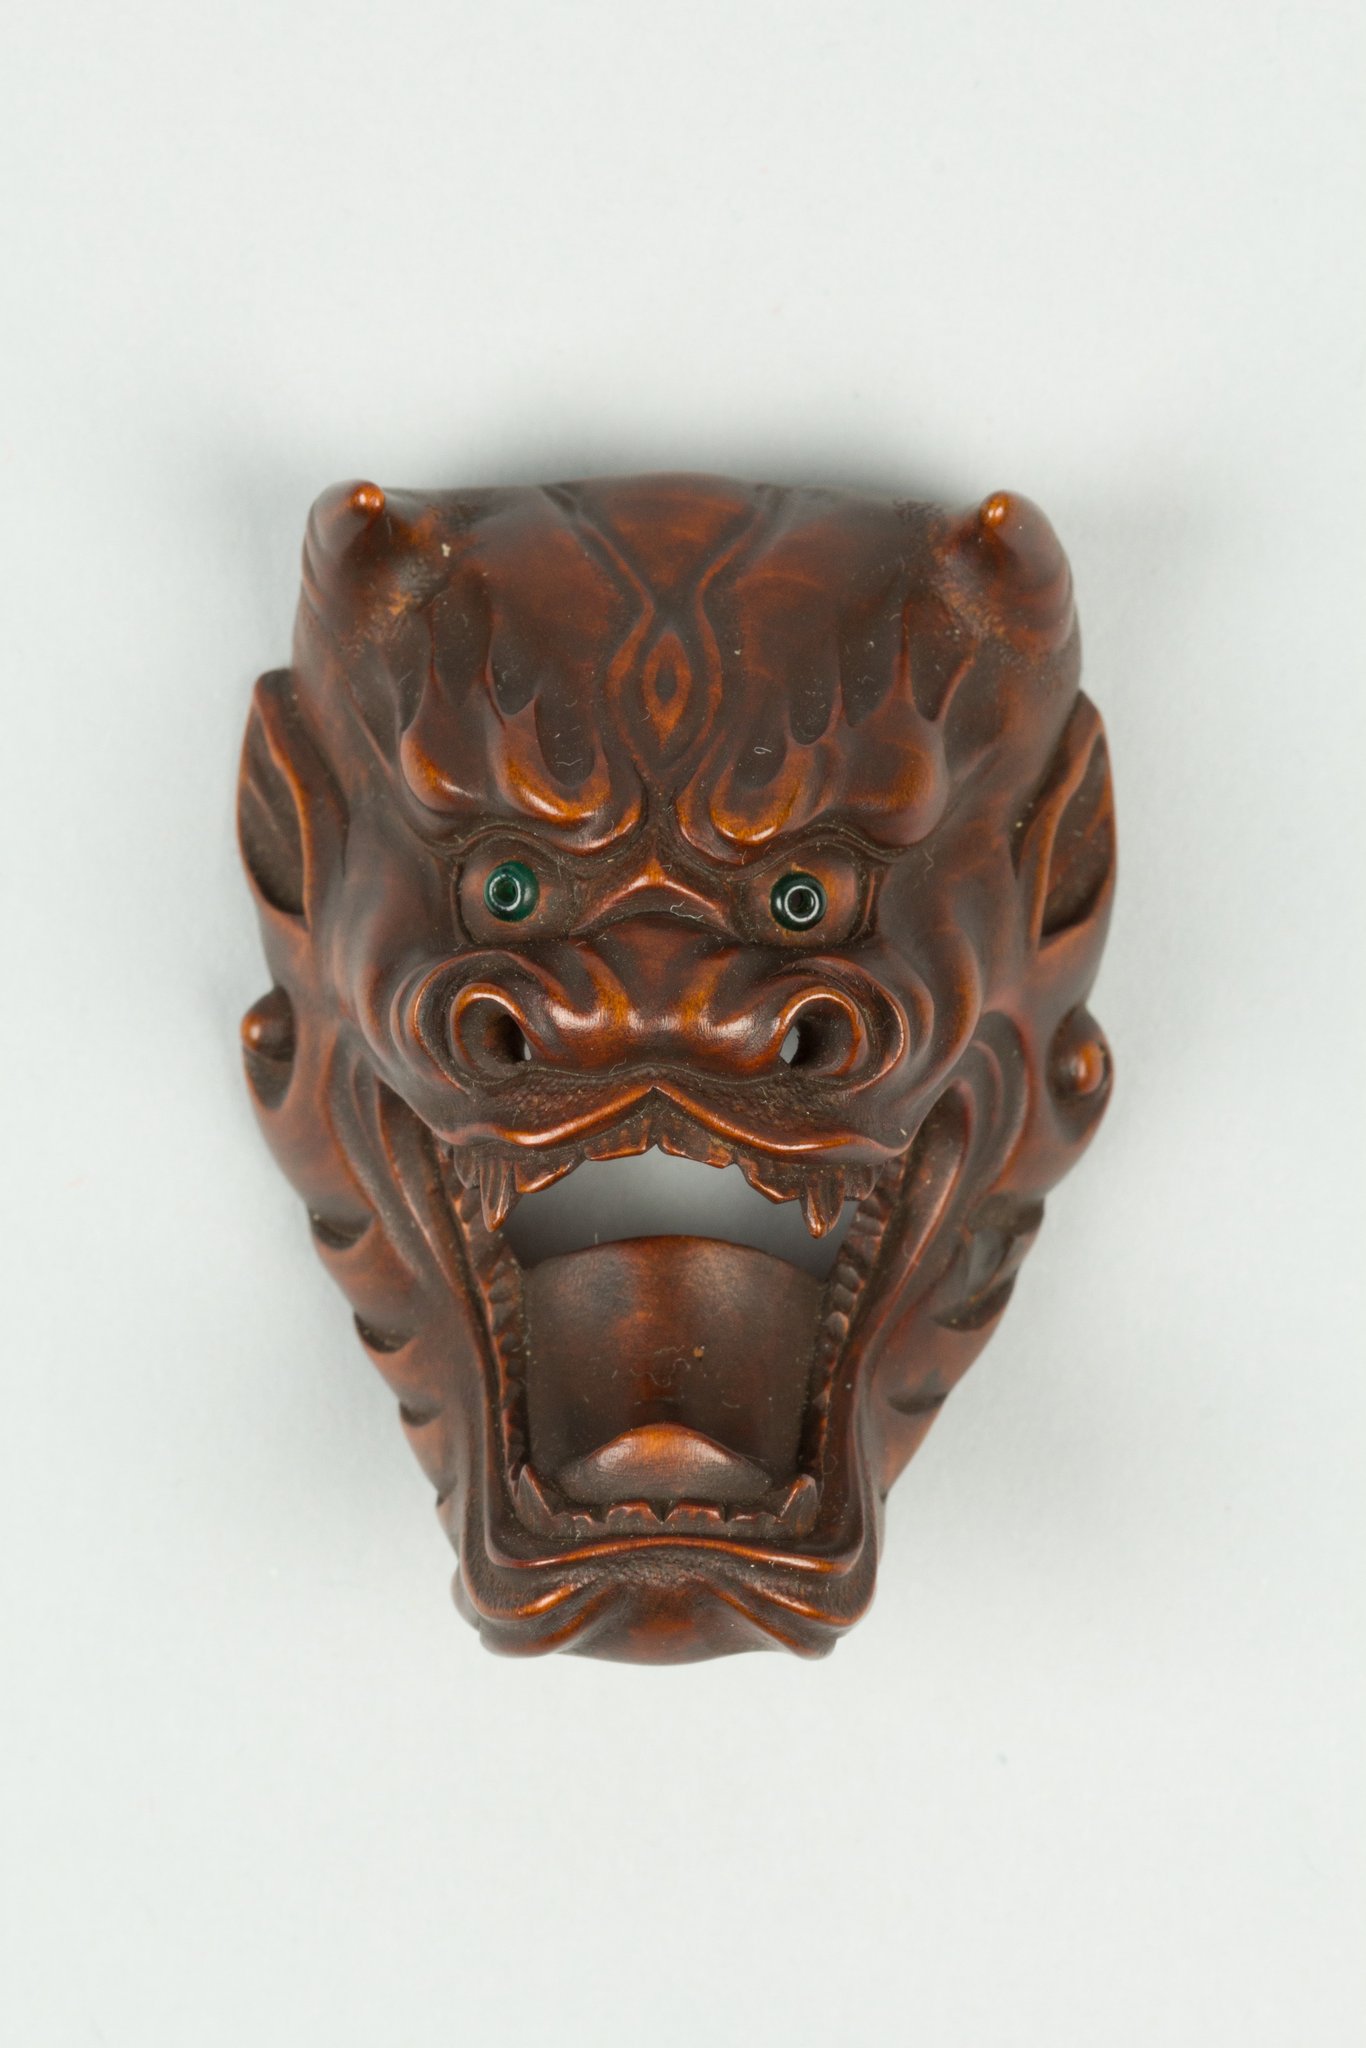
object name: netsuke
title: Netsuke of Devil Mask with Wide-Open Mouth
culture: japanese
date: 1801-1900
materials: glass, wood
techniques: inlay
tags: masks,devil